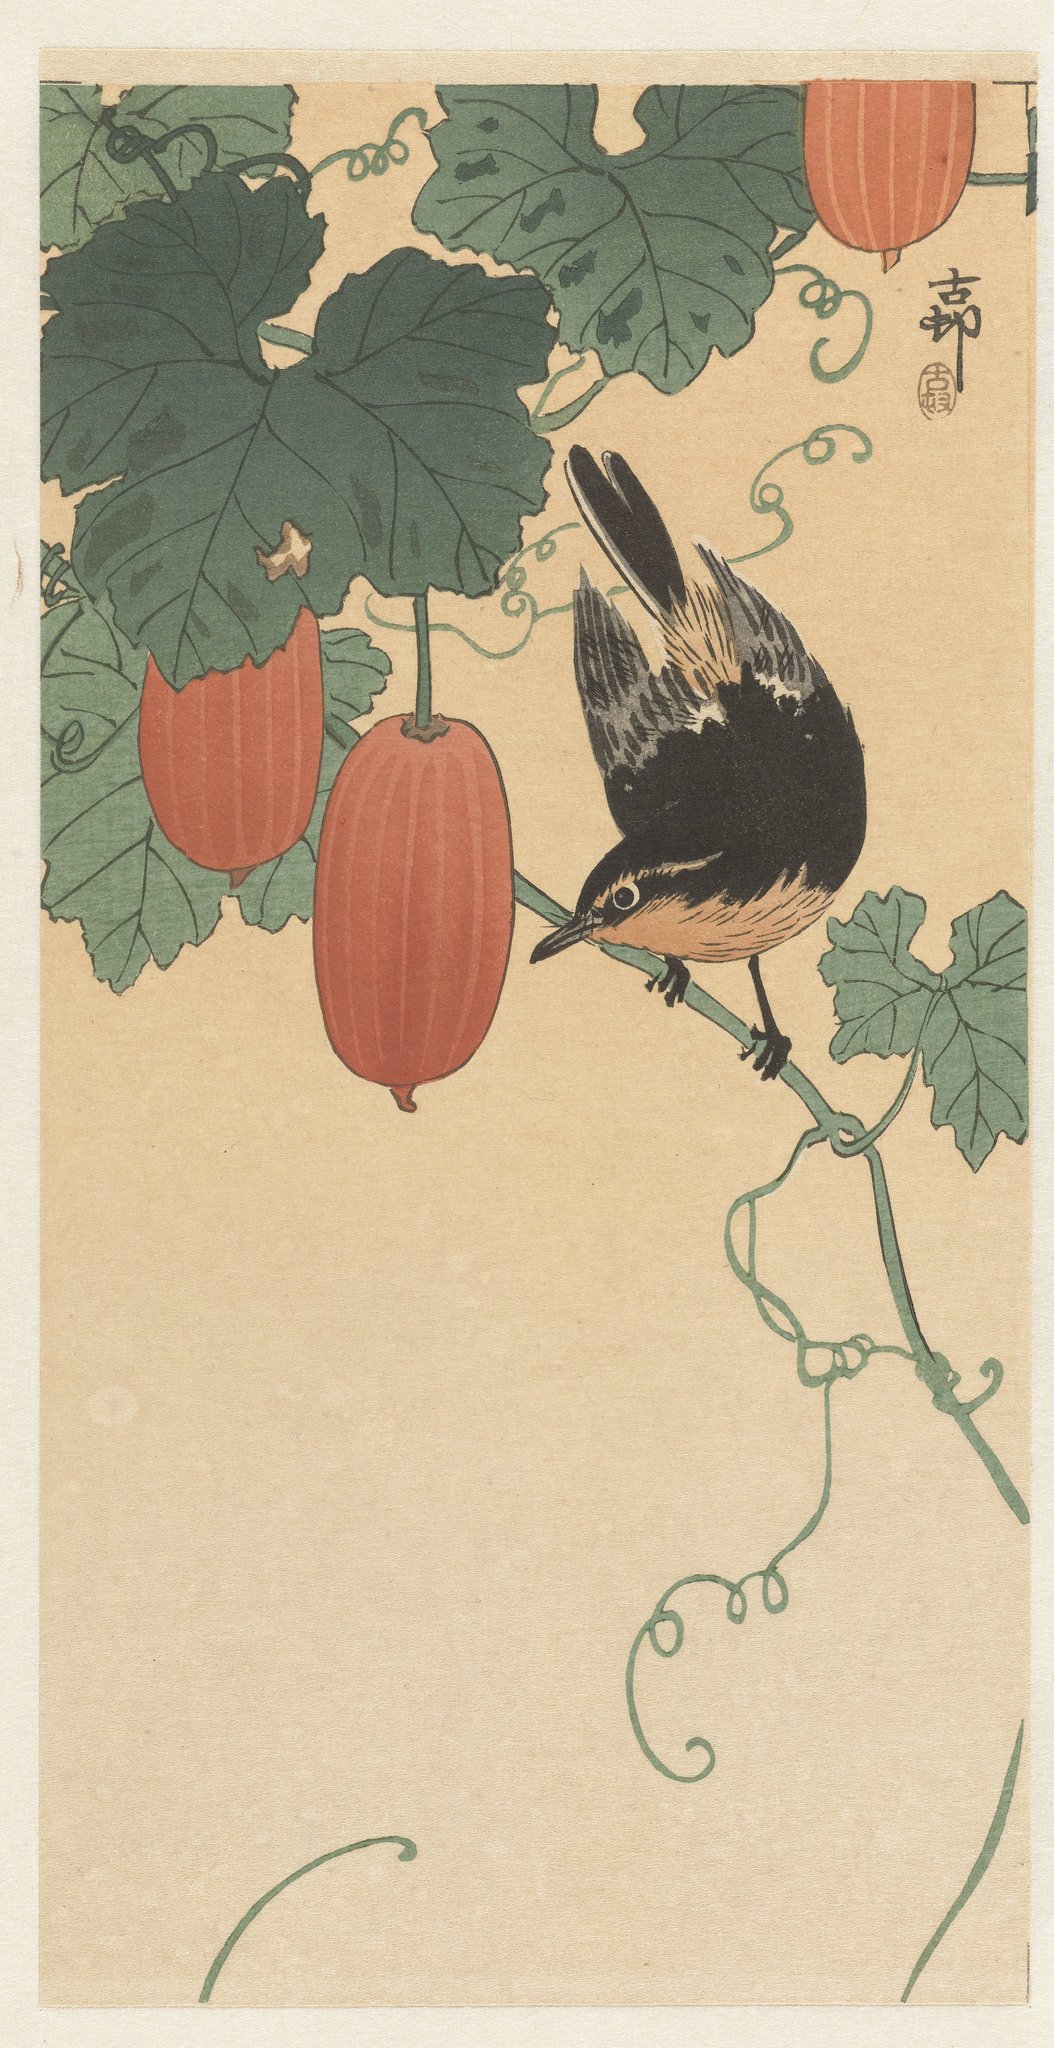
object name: print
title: Vogel en kaki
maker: ohara koson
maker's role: print maker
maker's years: 1877-1945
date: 1900-1930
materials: paper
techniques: woodcut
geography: japan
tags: birds, fruits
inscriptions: collector's mark: Lugt 2228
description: Tak met drie rode kaki vruchten, waarop vogeltje.